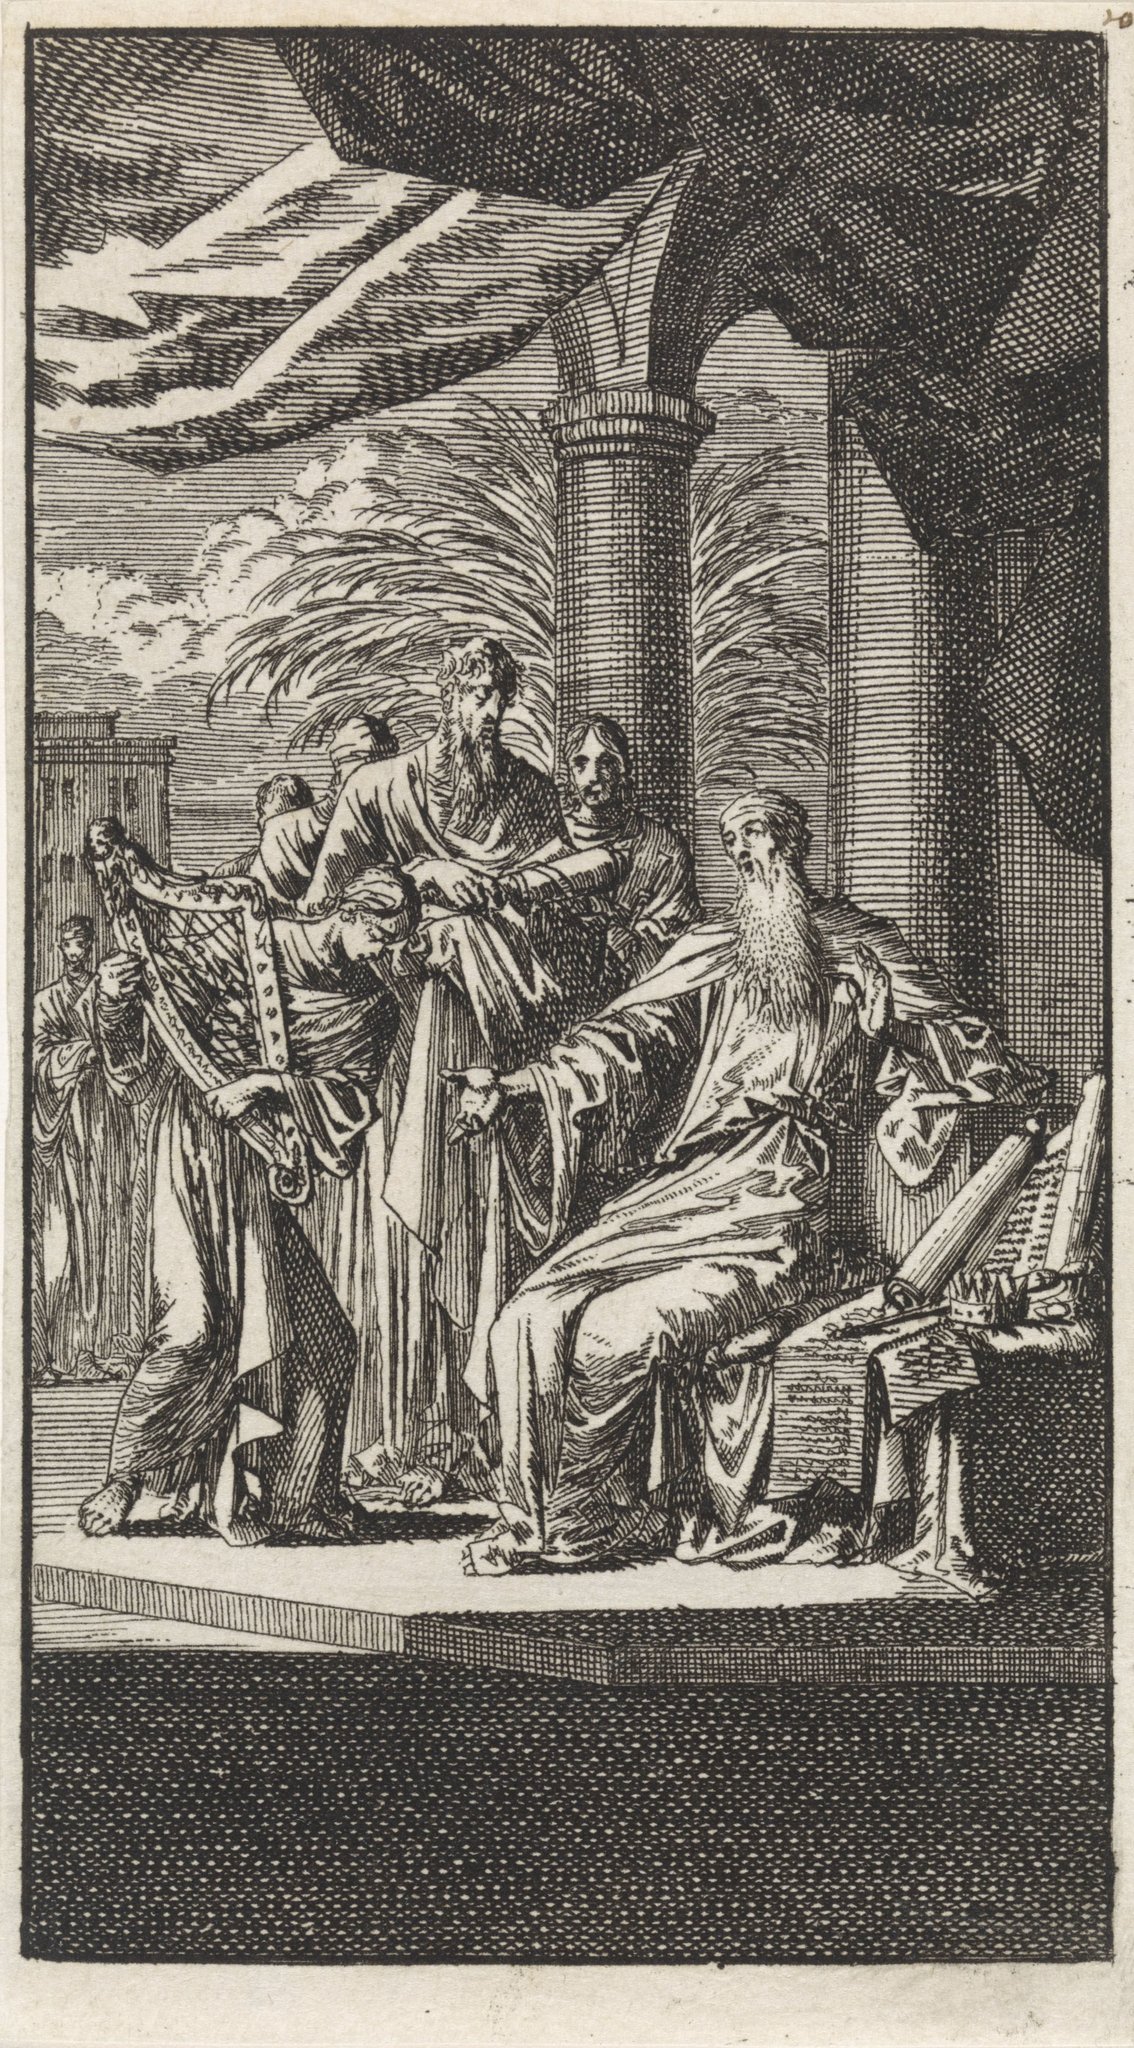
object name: print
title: Koning David ontvangt zijn harp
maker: jan luyken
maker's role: draughtsman, print maker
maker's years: 1649-1712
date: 1712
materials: paper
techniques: etching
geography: amsterdam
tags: david as harpist at saul's court (1 samuel 16:14-23)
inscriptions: collector's mark: Lugt 2228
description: Proefdruk van illustratie voor: Luyken, Jan. Bybel printen. Amsterdam: Pieter Arentsz. II (wed.) en Cornelis van der Sys, 1712, p. 14.